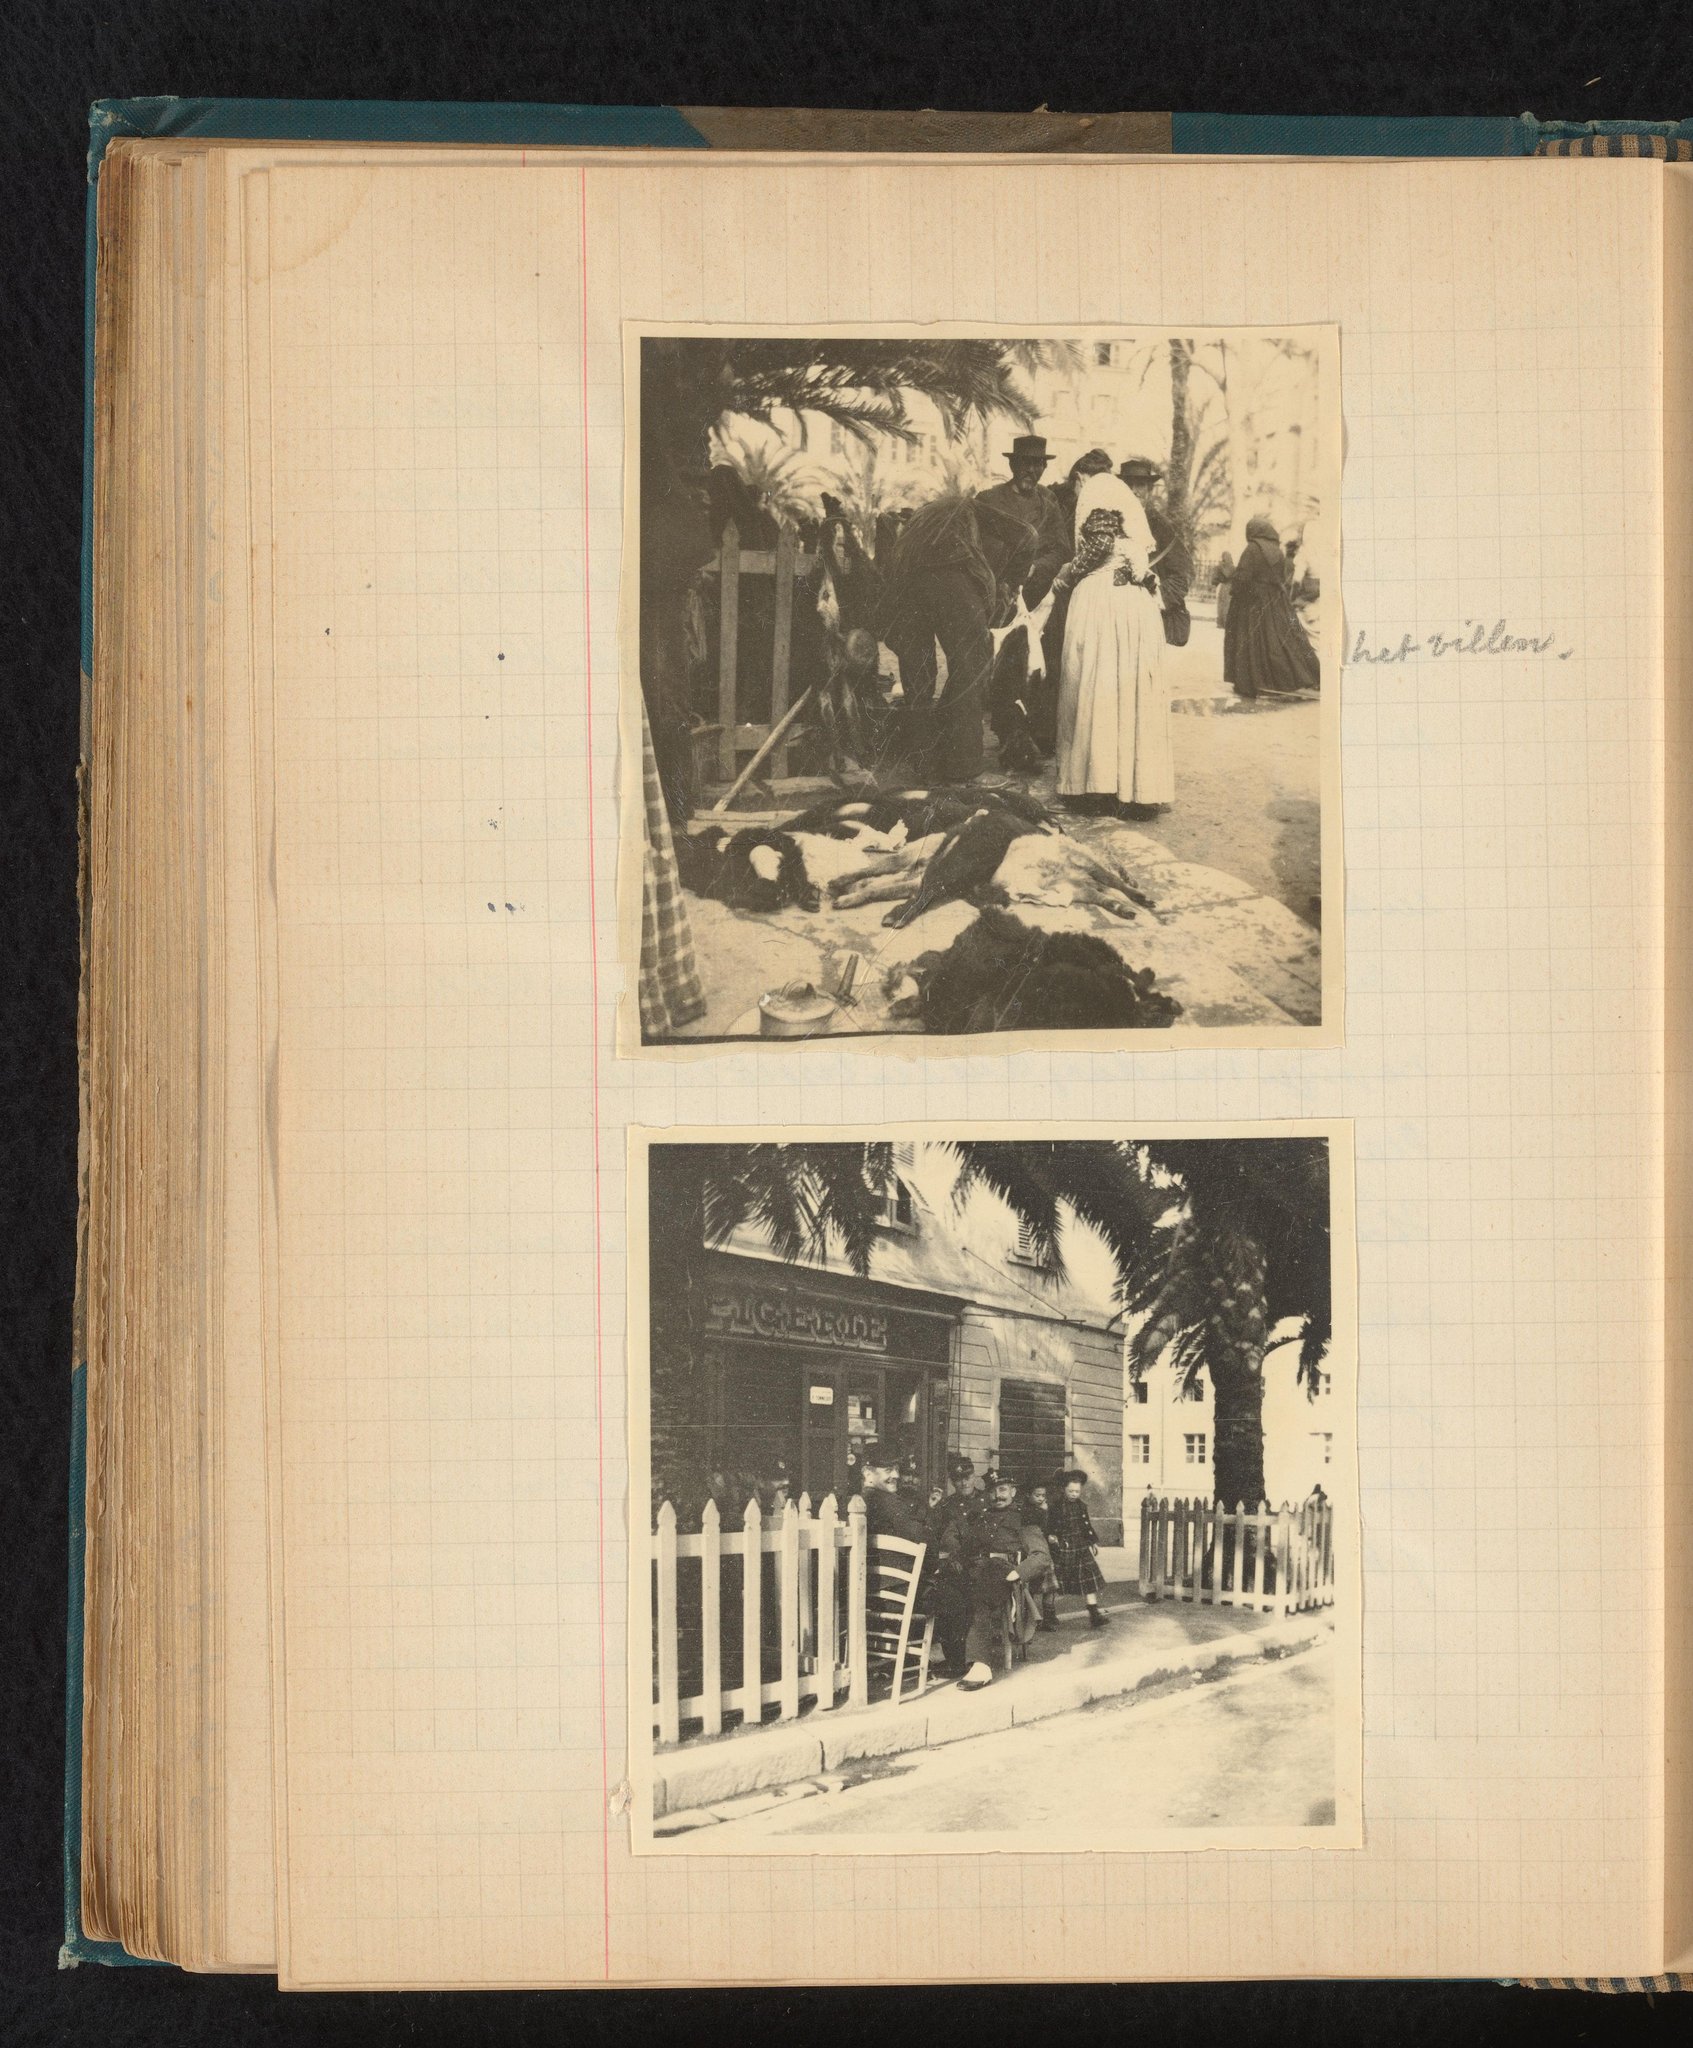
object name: album leaf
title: Kooplieden villen kalven op een markt en officieren op het terras van een café nabij Place des Palmiers, Ajaccio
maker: théodore van lelyveld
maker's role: painter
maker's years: 1867-1954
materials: paper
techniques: gelatin silver print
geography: ajaccio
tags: pavement, terrace in front of inn or restaurant, market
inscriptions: inscription: ‘het villen’